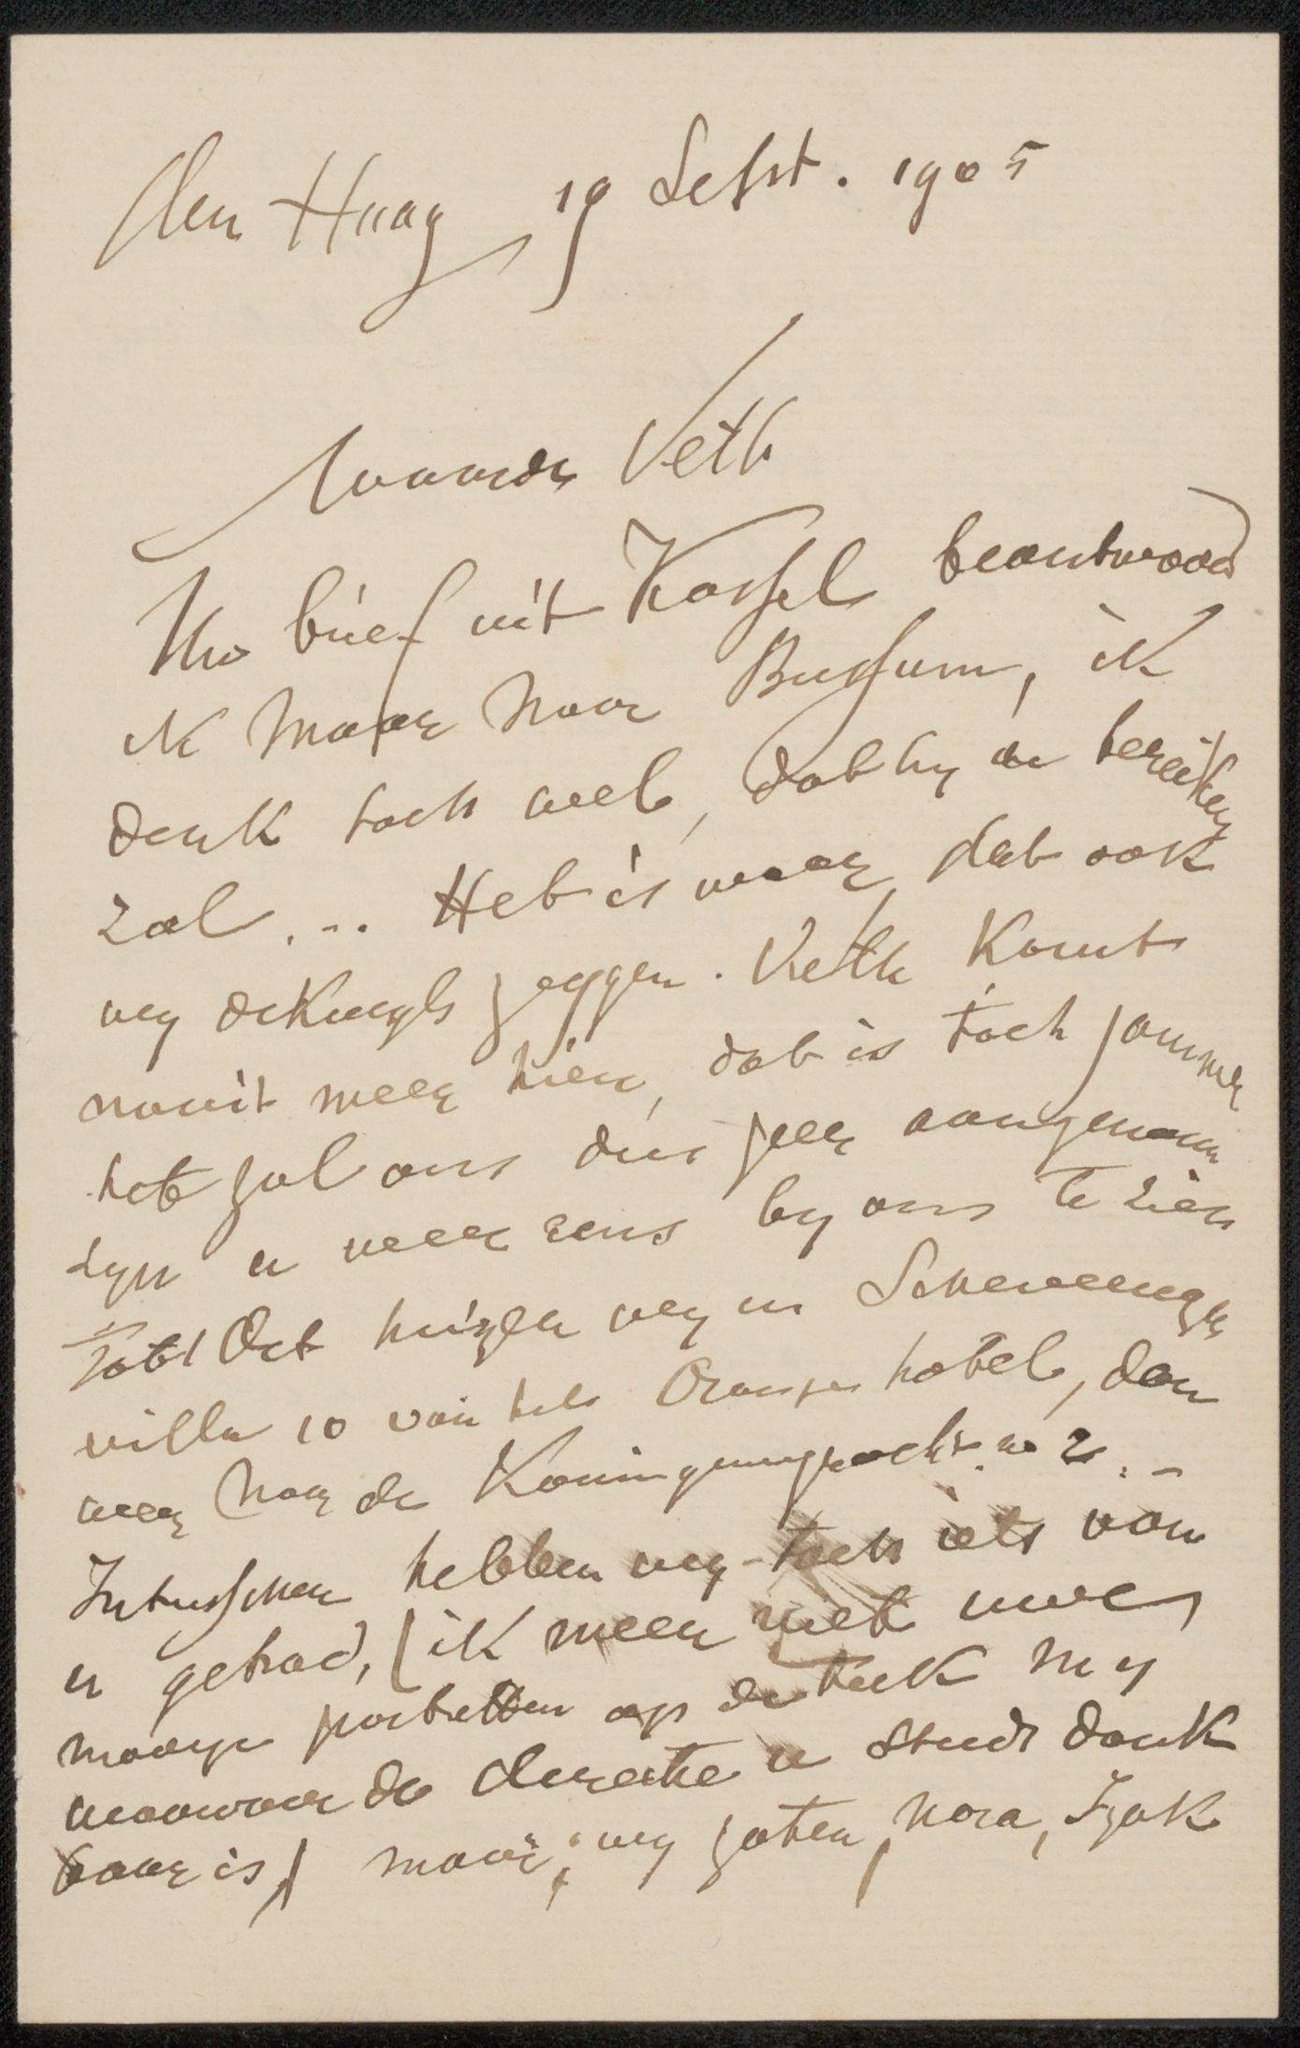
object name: letter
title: Brief aan Jan Veth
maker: jozef israëls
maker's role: draughtsman, painter, print maker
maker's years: 1824-1911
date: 1905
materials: ink, paper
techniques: pen, writing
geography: the hague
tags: dordrecht, amsterdam, designer, jan veth, the graphic arts, historical persons (portraits and scenes from the life)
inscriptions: watermark, collector's mark: ‘RPK’